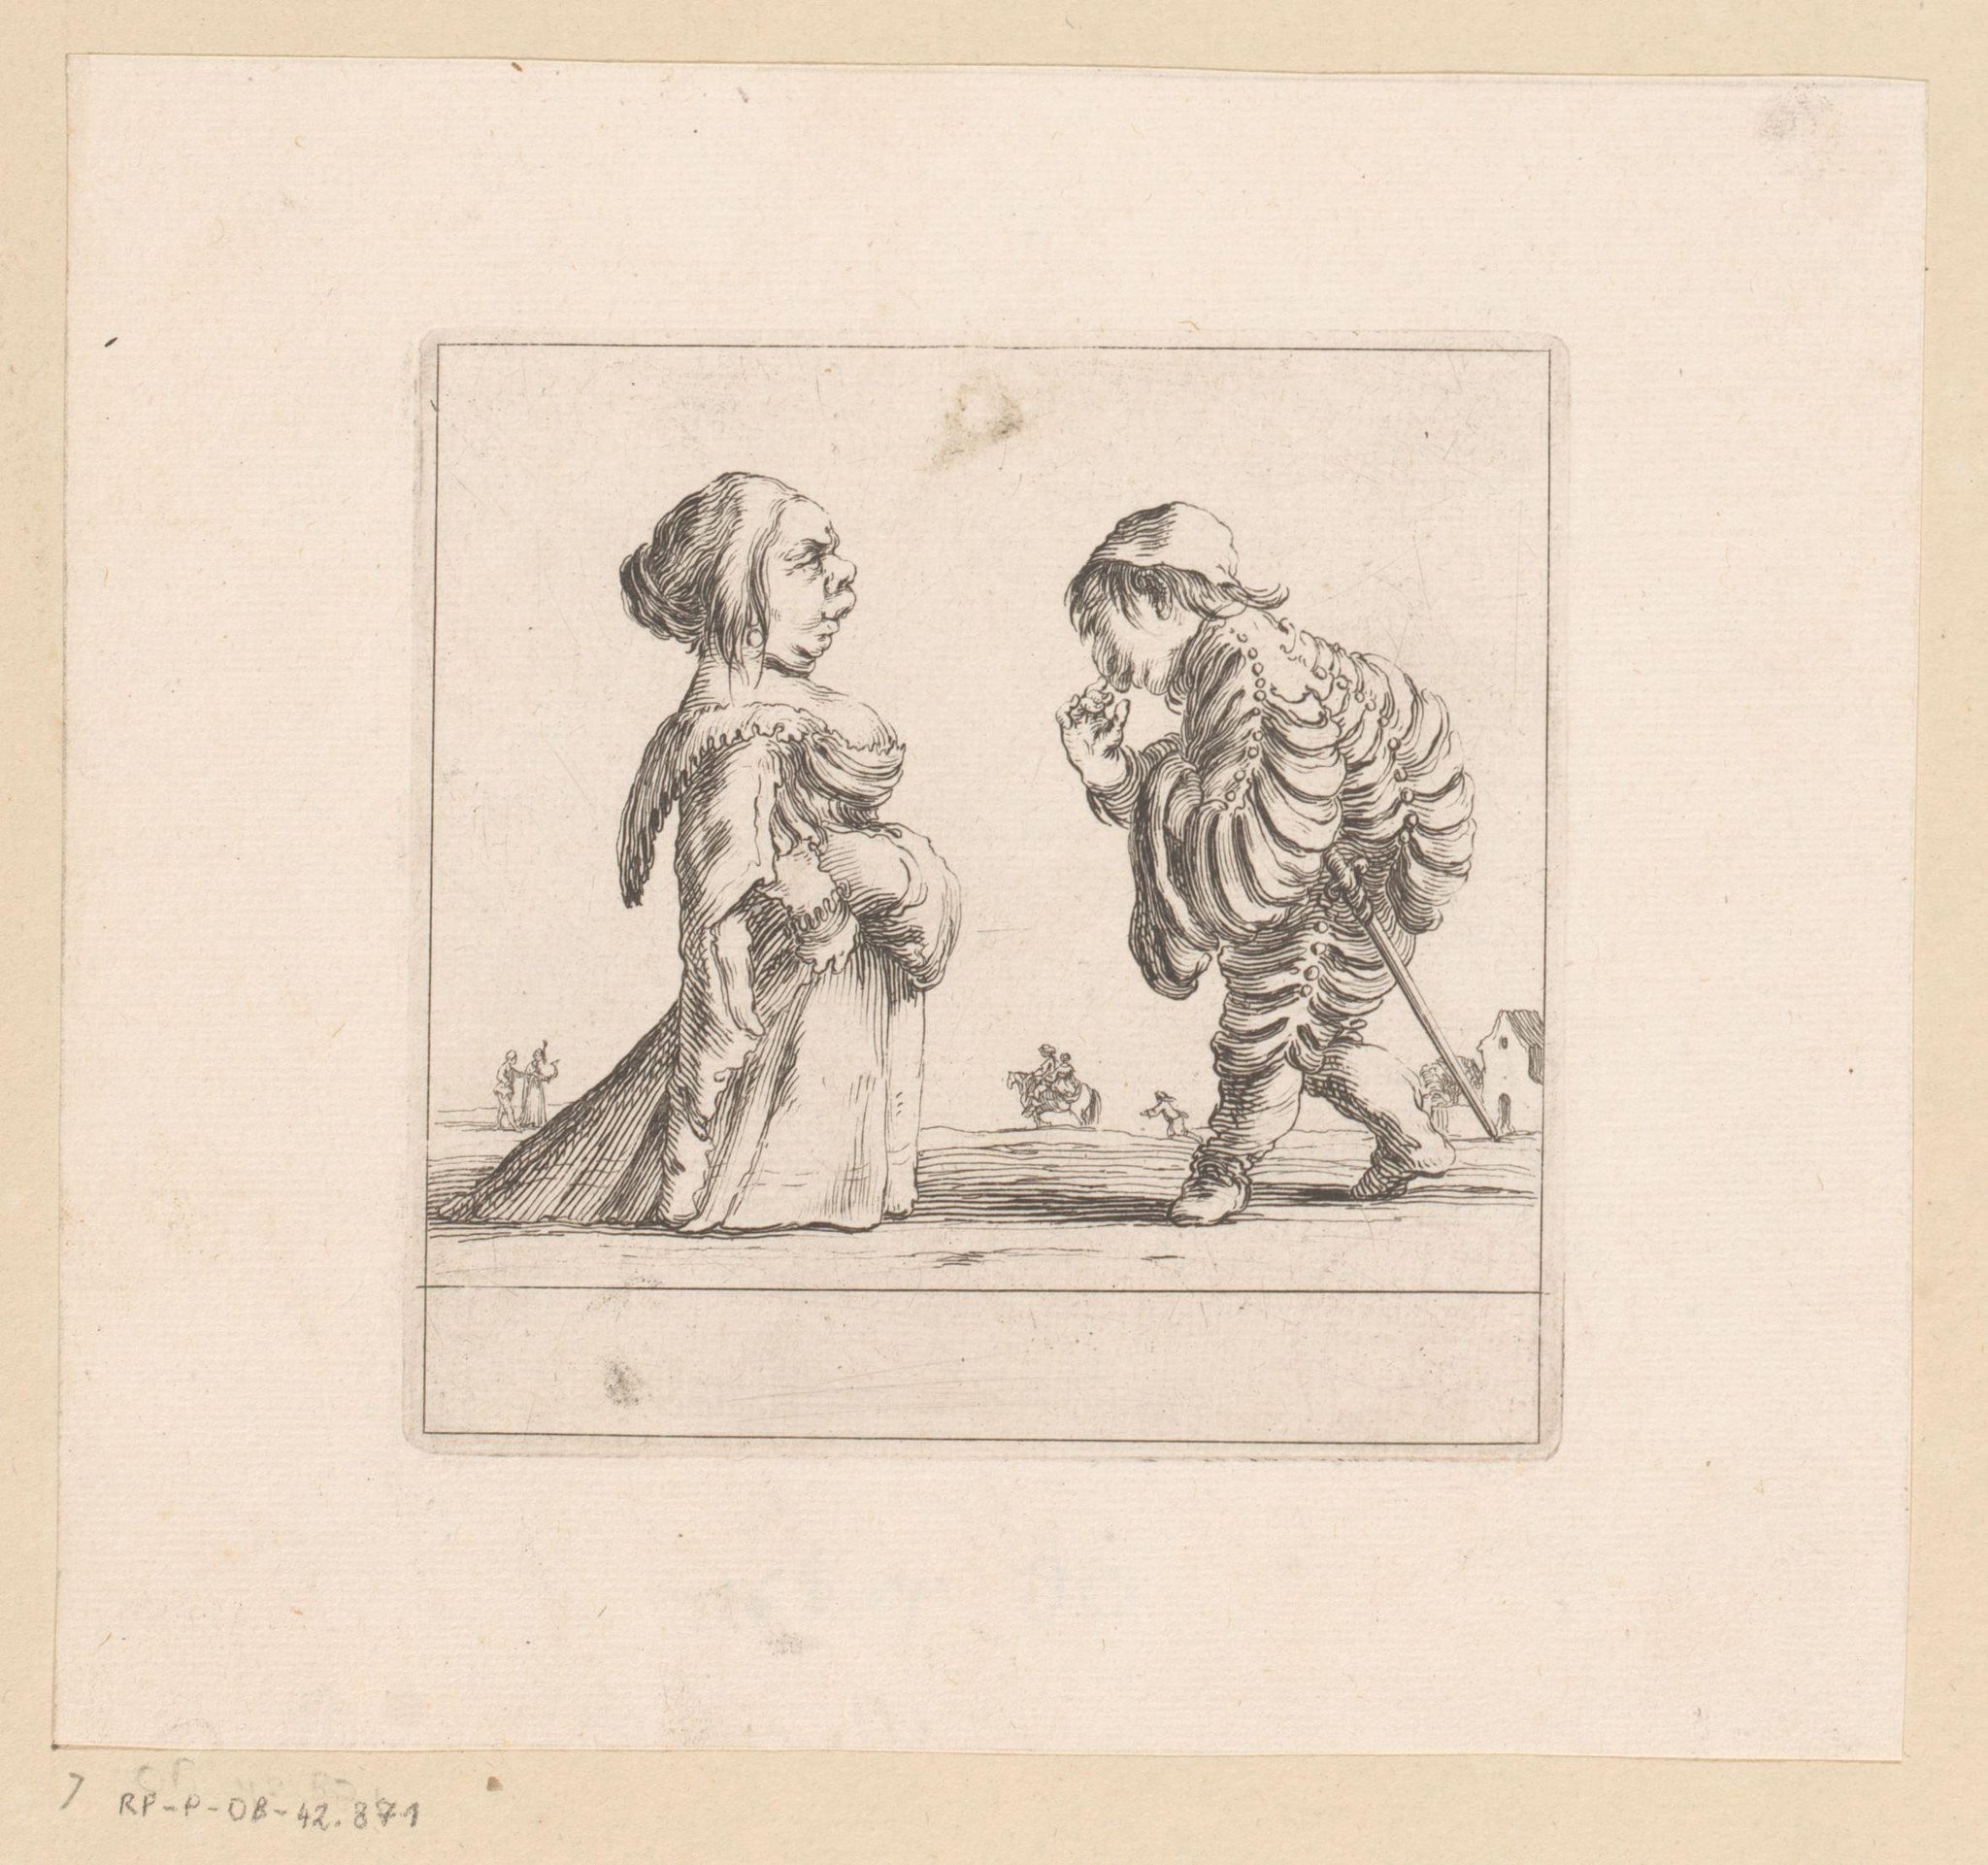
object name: print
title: Karikaturale voorstelling van een man en een vrouw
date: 1620-1687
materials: paper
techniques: engraving, etching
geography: france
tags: adult woman, caricatures (human types), adult man, courting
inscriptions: collector's mark: Lugt 240